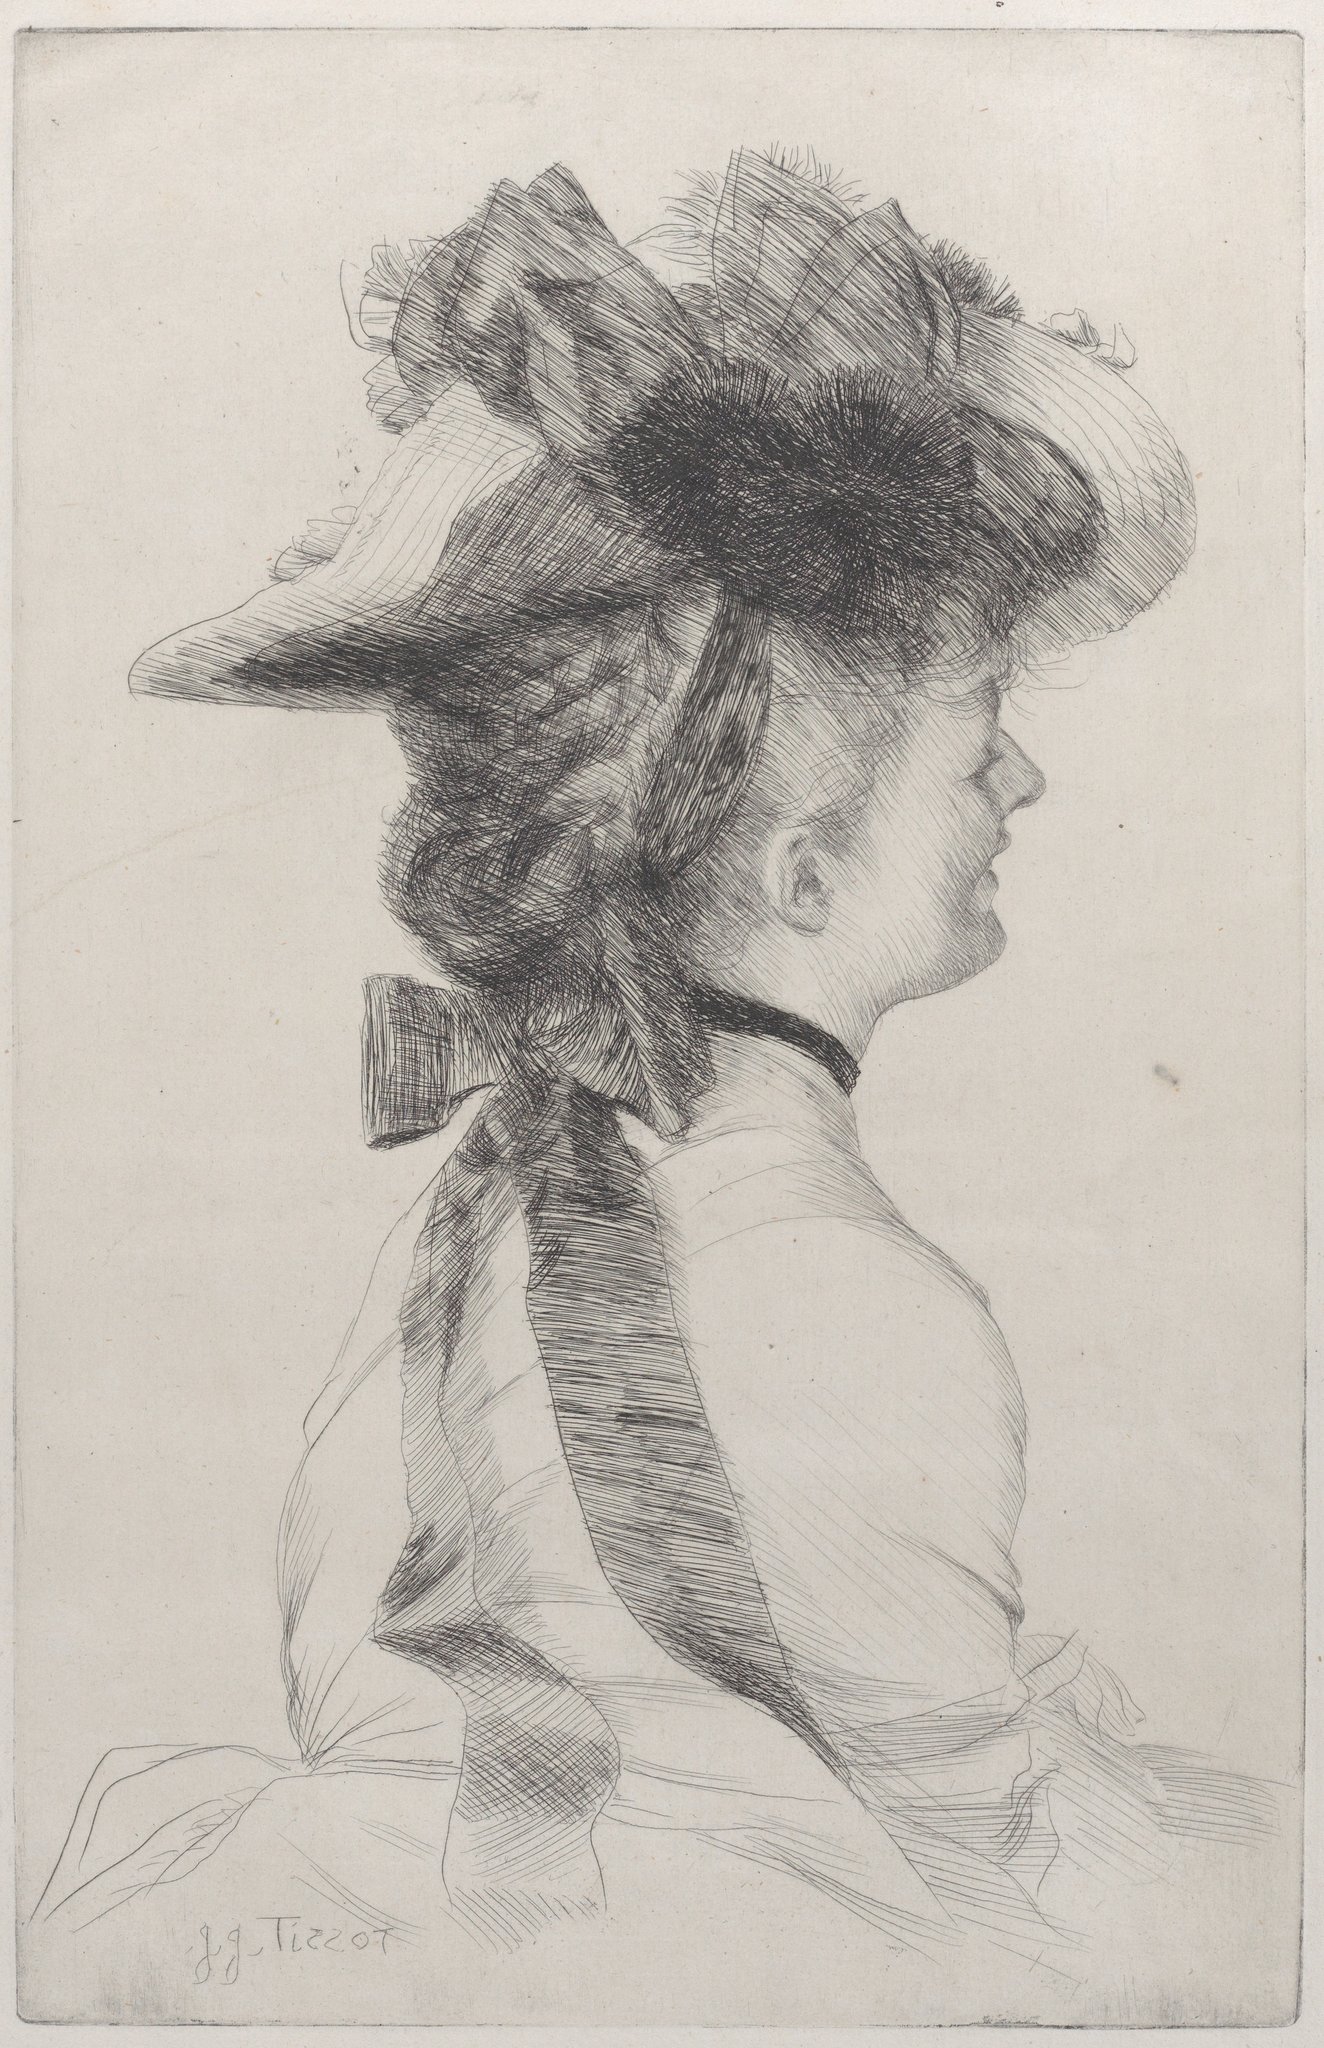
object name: print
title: The Rubens Hat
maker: james tissot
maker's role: artist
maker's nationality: french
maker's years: 1836-1902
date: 1875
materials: paper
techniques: etching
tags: profiles,women